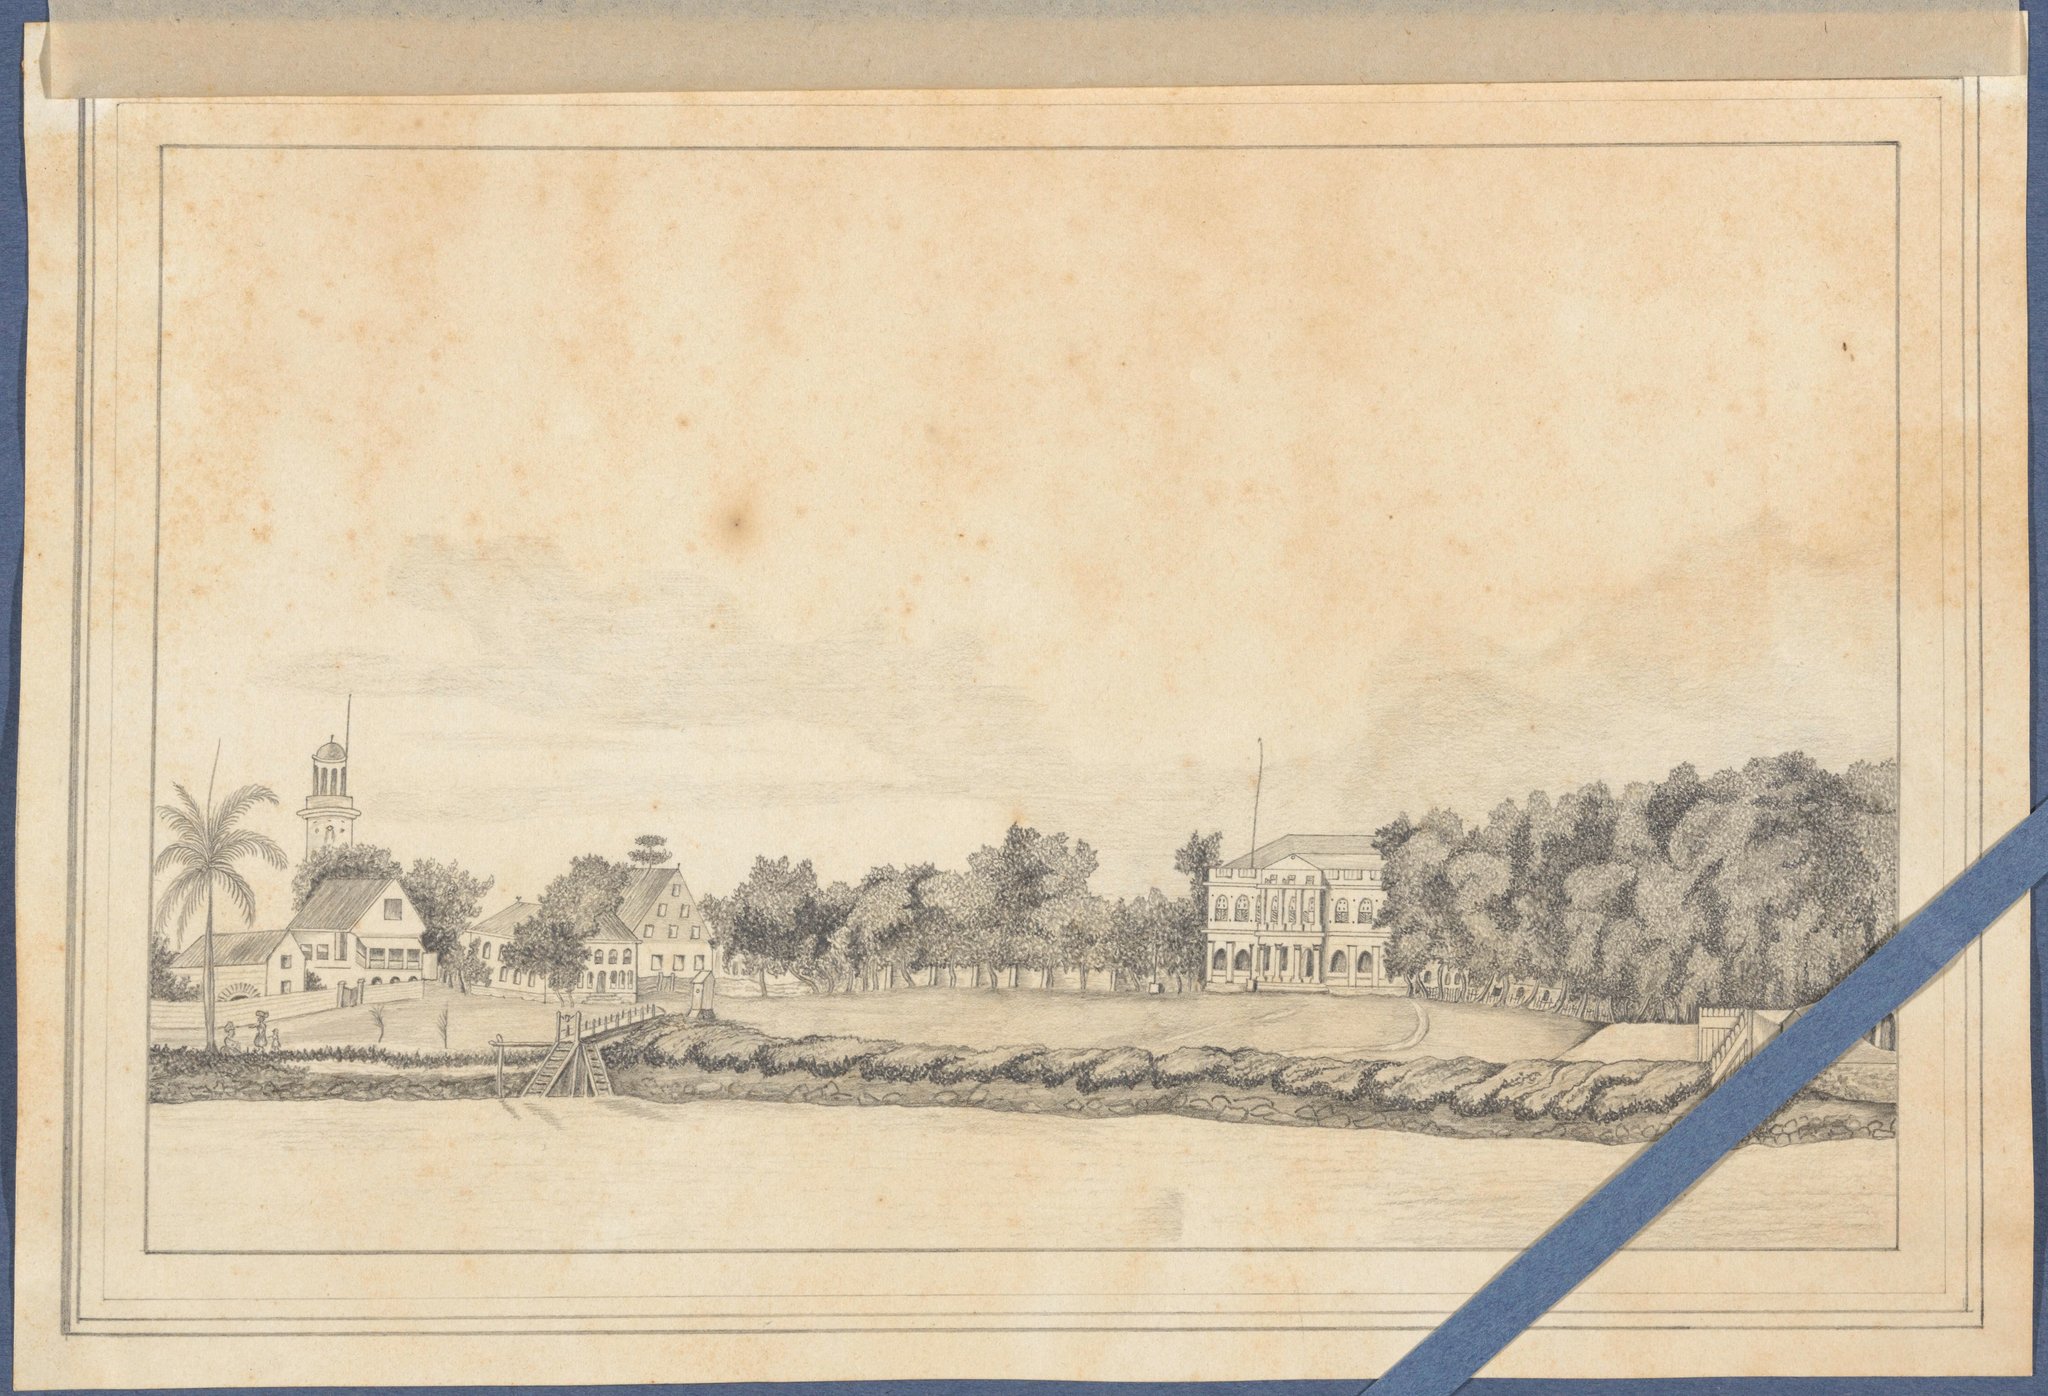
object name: album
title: Familiealbum van de familie Boekhoudt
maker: h. buringh boekhoudt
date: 1920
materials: paper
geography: netherlands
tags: suriname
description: Familiealbum met onder meer stambomen van de verschillende takken van de familie, portretten van familieleden vanaf de 18e eeuw, diploma’s, getuigschriften en foto’s.